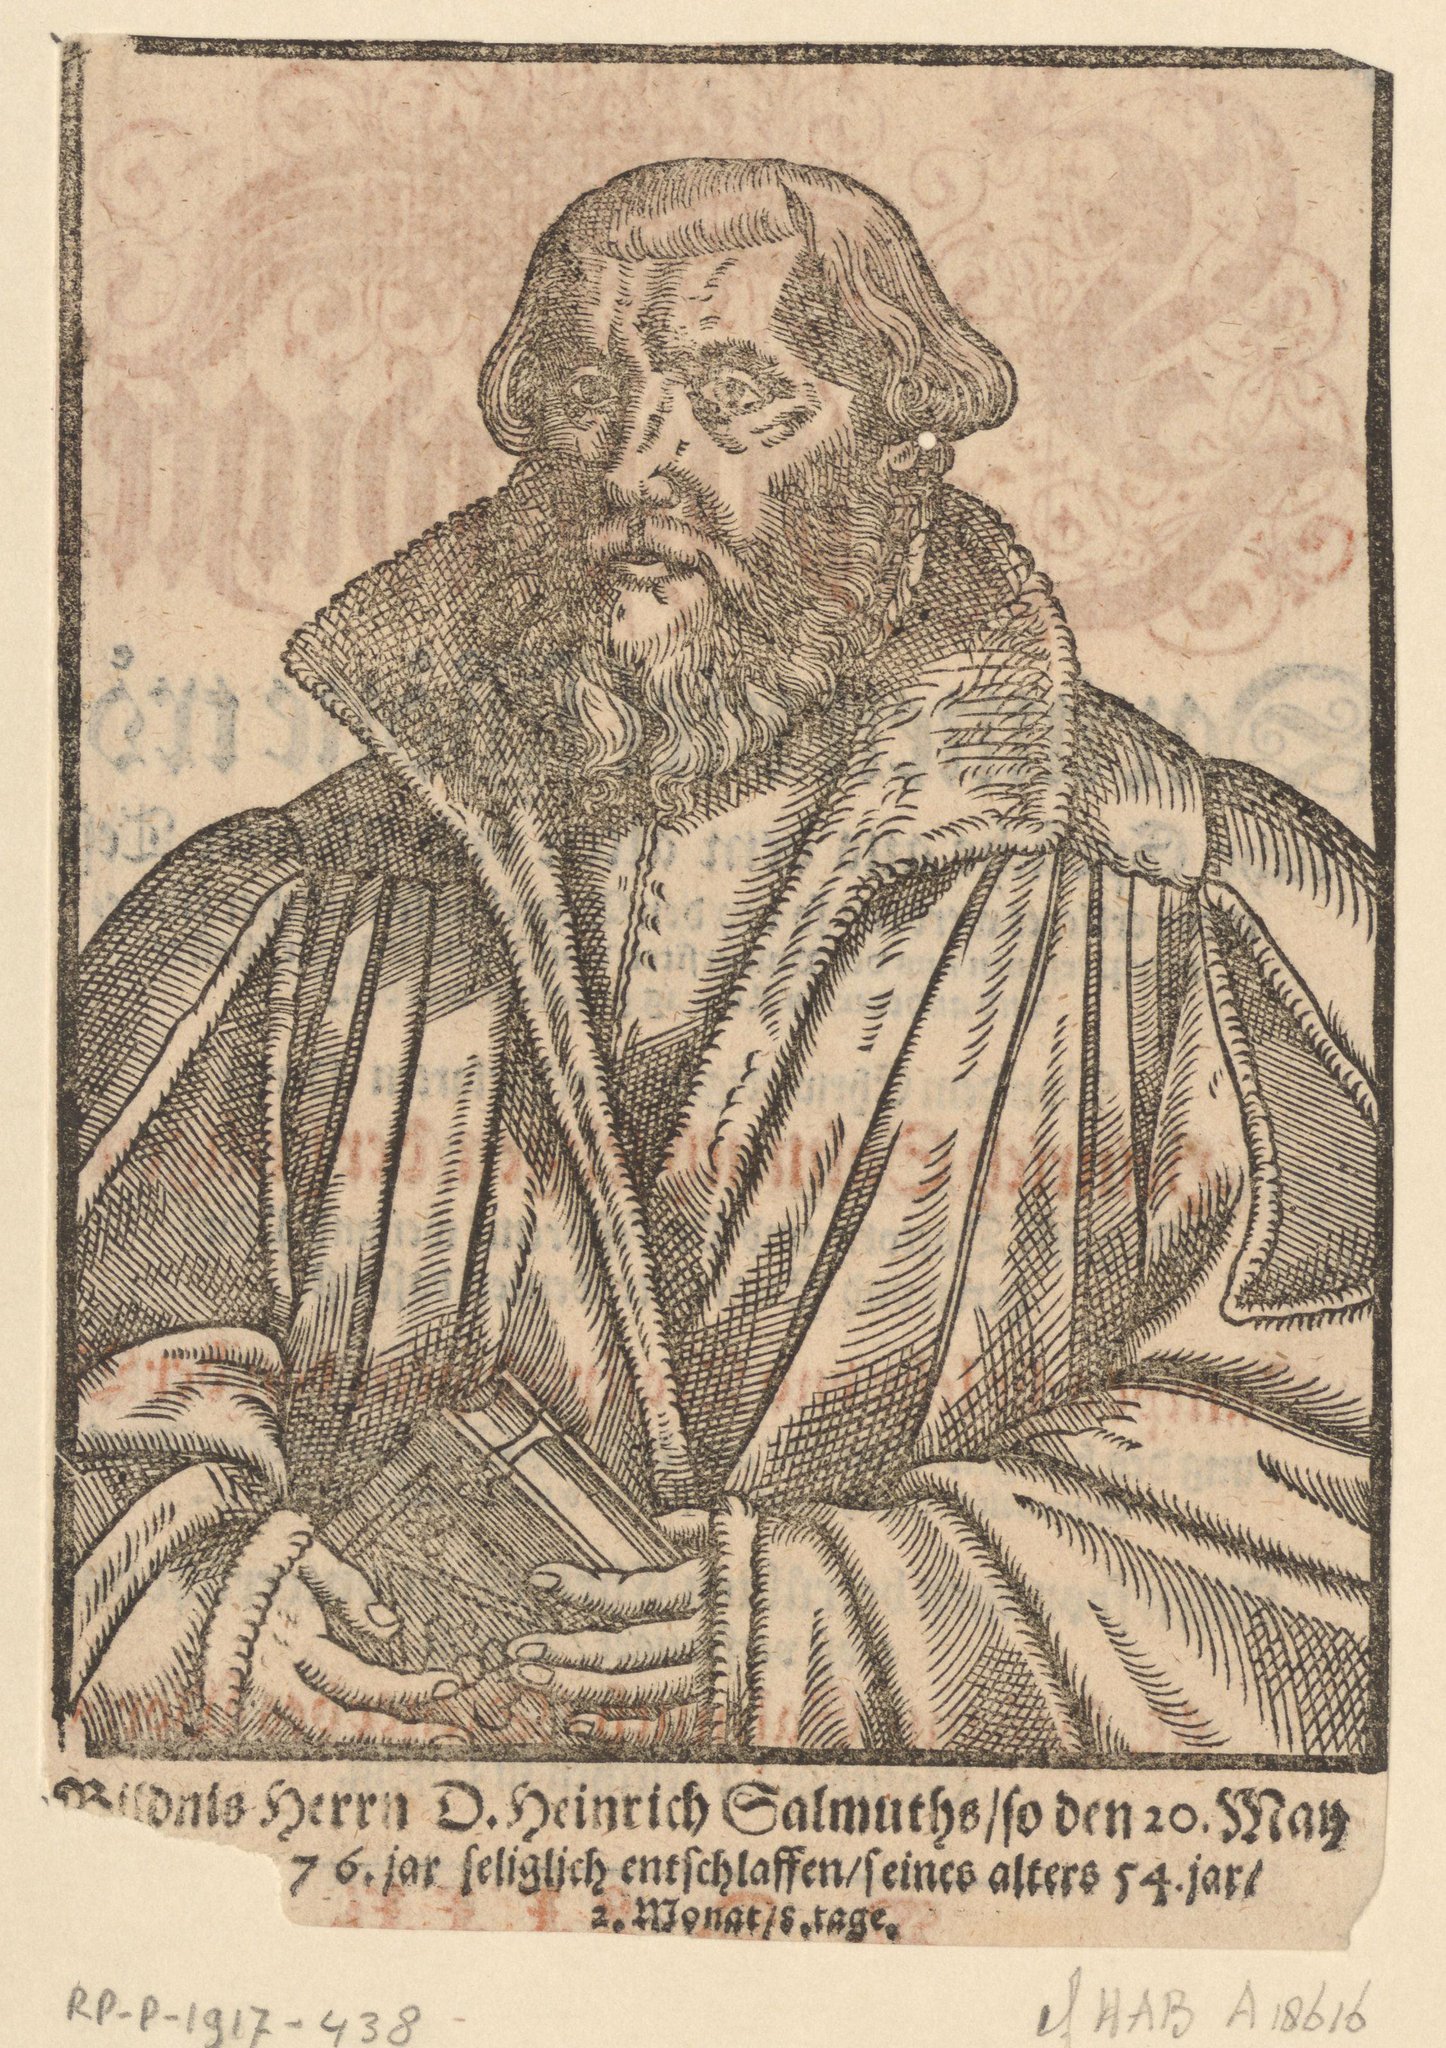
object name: print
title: Portret van Heinrich Salmuth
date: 1581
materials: paper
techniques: letterpress printing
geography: leipzig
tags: theologian, historical persons, book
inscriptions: collector's mark: Lugt 2228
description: Prent uit: Salmuth, Heinrich. Leychpredigten, darinnen viel schöne tröstliche Sprüche aus dem alten und Newen Testament erkleret werden (...). Leipzig: Henning Gross, 1581.